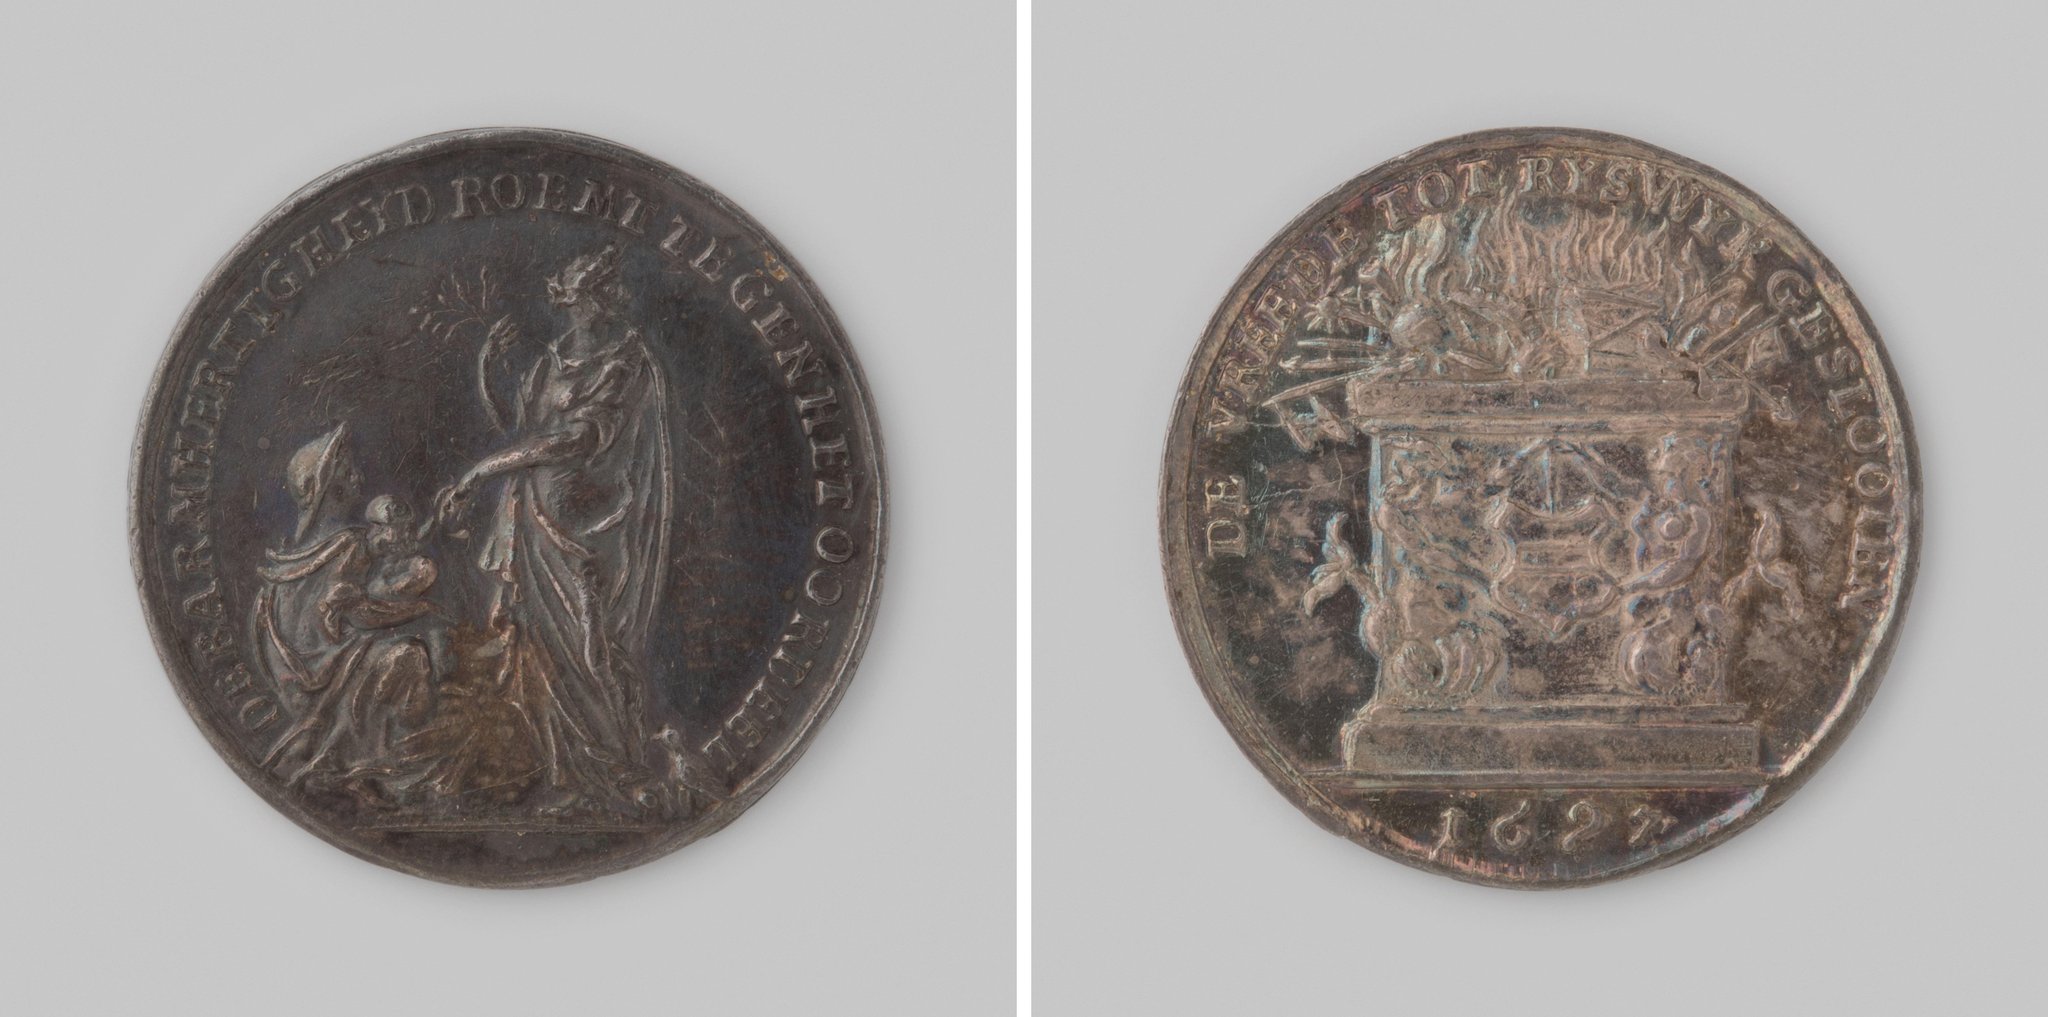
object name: history medal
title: Vrede van Rijswijk (Muidense loterij) 1697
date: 1697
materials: silver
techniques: striking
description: Zilveren penninkje, op de voorzijde de Barmhartigheid met vredestak die moeder met kind troost (in het midden een vogeltje, links I.I.F.), met omschrift, op de keerzijde een altaar, versierd met het wapen van Muiden, waarop oorlogstuig verbrand wordt, met omschrift.